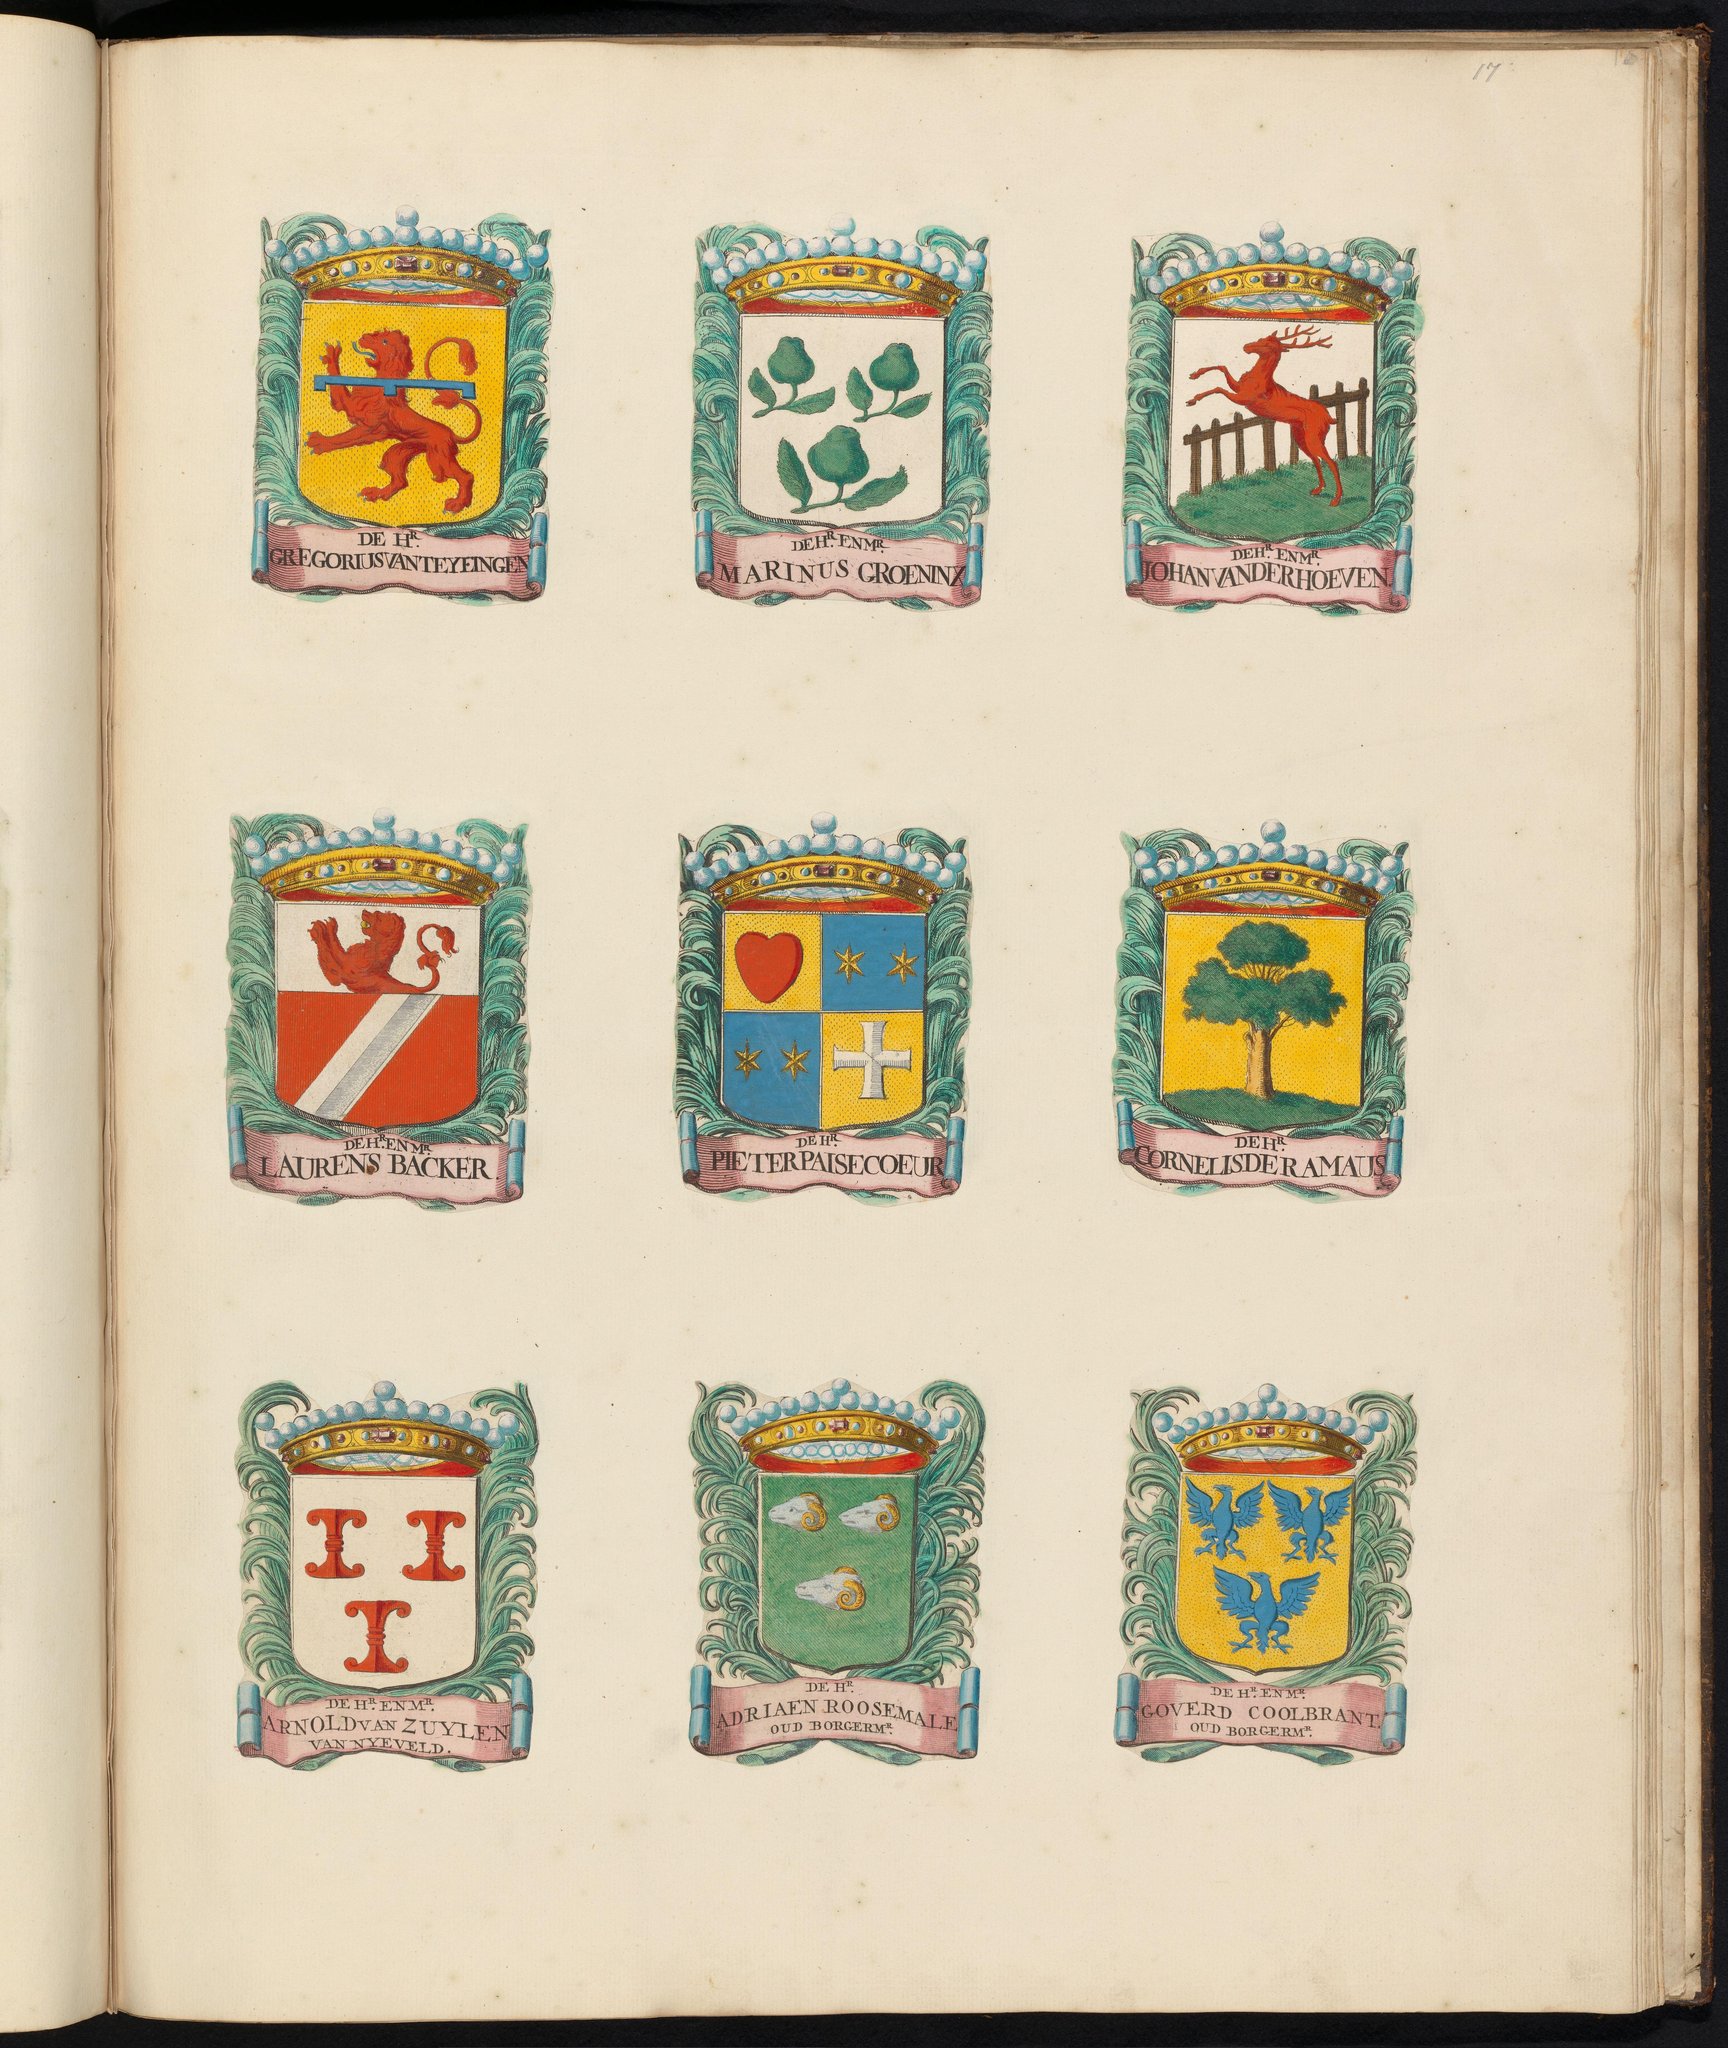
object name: album leaf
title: Negen wapens van raden in de vroedschap van Rotterdam, rechtsboven het wapen van Johan van der Hoeven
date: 1694-1695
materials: paper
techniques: colour, etching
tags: amsterdam, rotterdam, mayor, coat of arms (as symbol of the state, etc.)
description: Negen voorstellingen op een albumblad. Het betreft negen wapen van raden in de vroedschap van Rotterdam. De prenten zijn onderdeel van de kaart van Rotterdam door Johannes de Vouw en maken deel uit van een album.